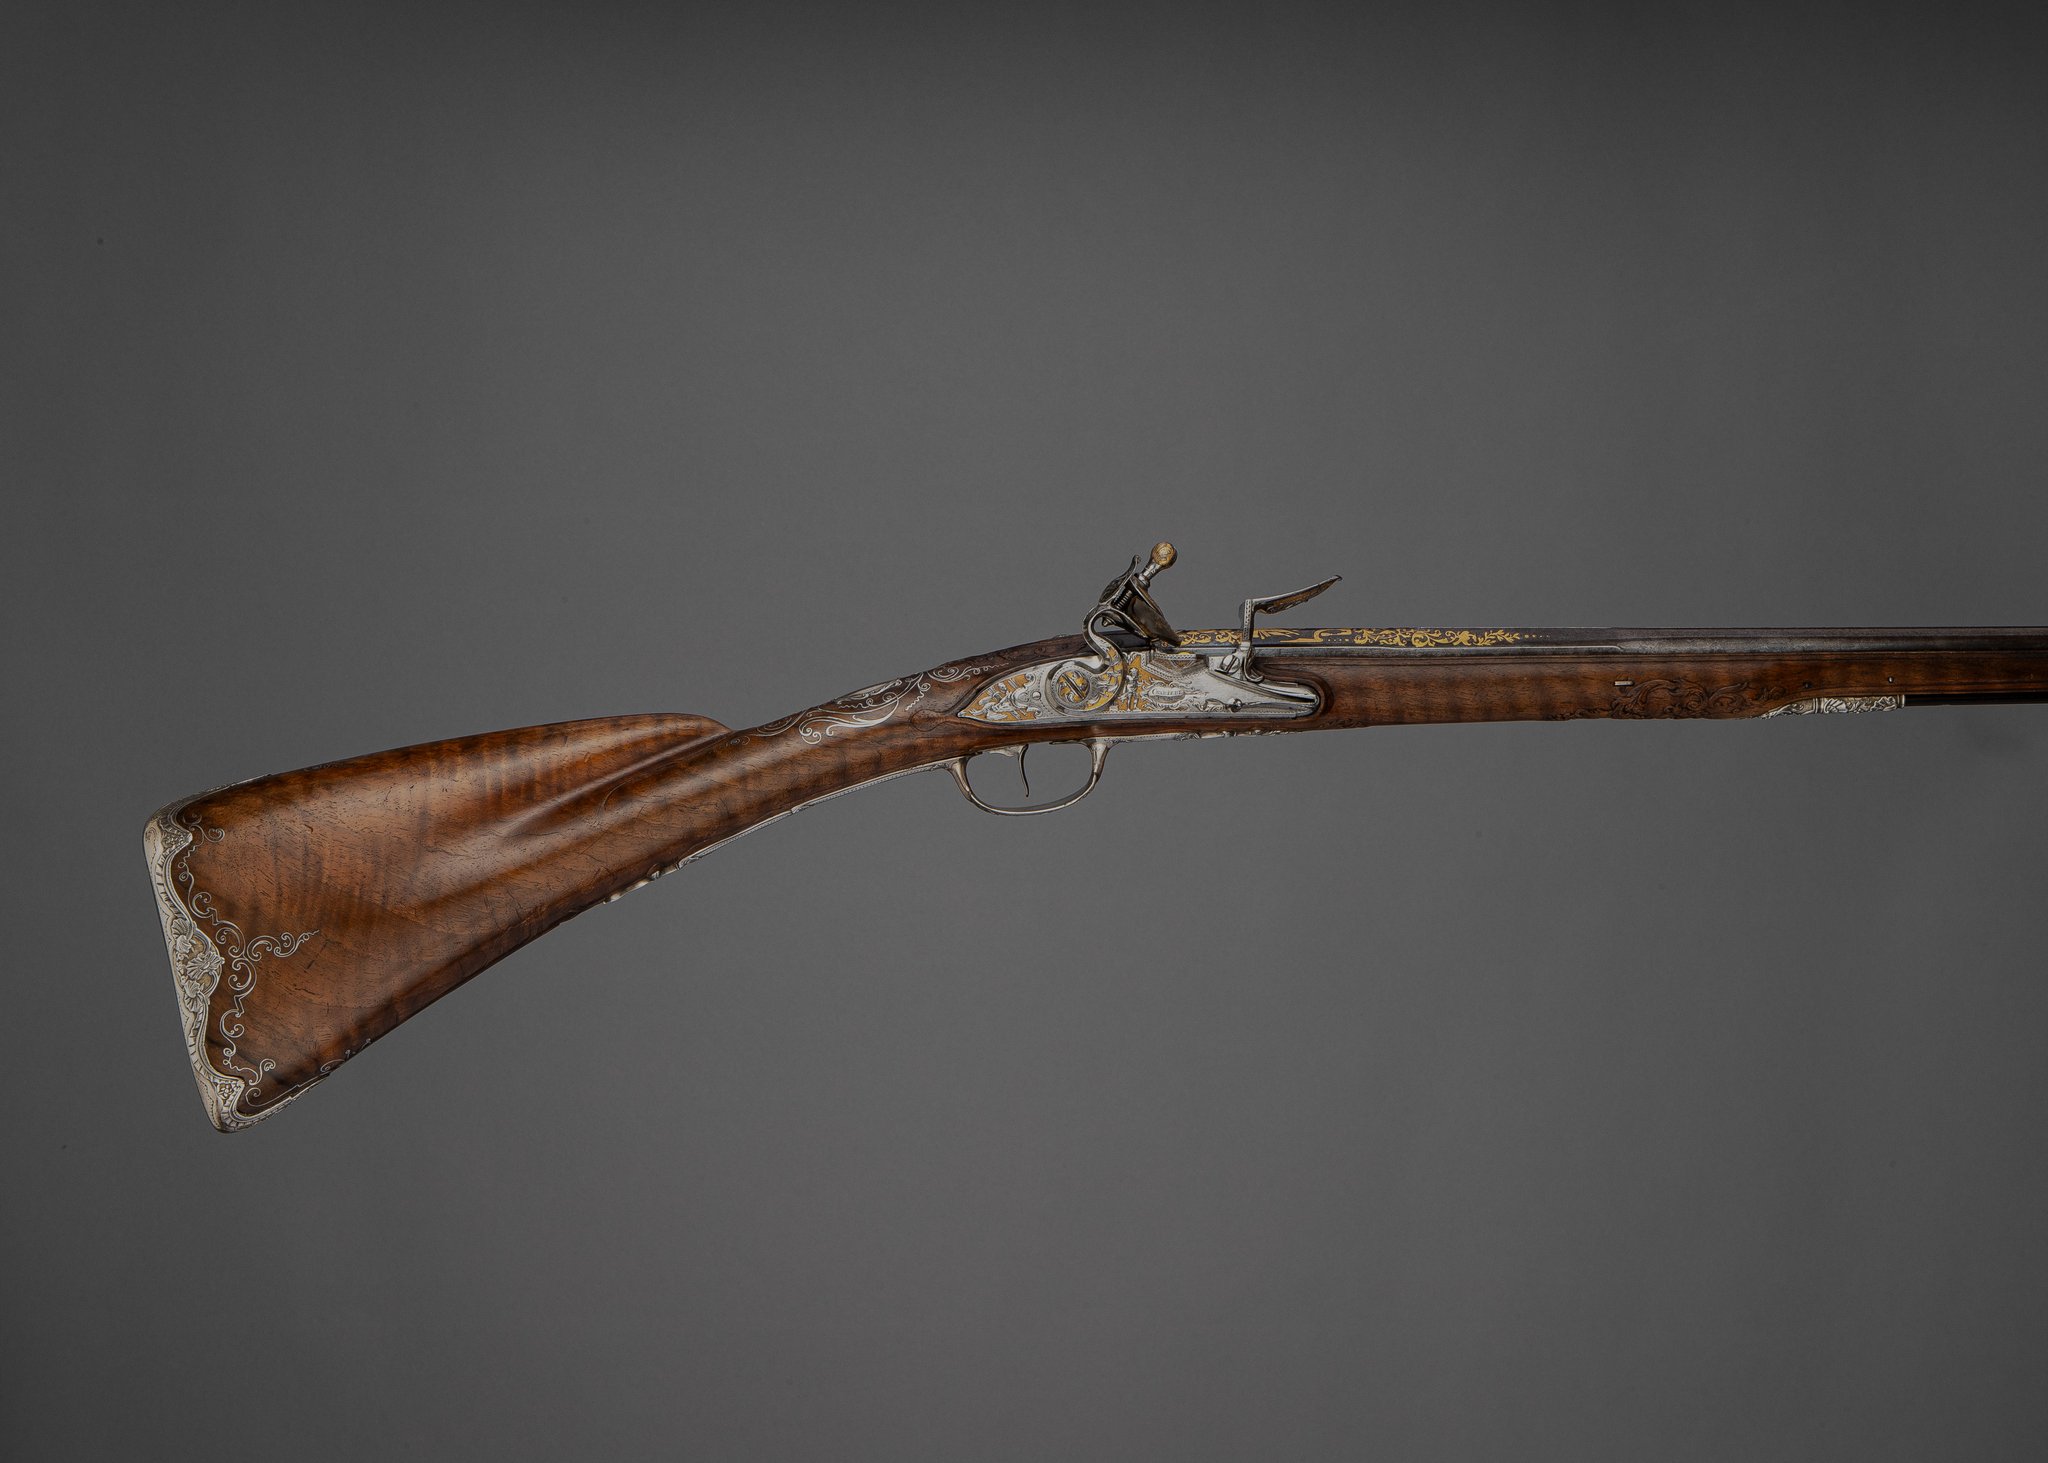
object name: flintlock pistol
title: Flintlock Gun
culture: french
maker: jean-joseph charrière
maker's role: gunsmith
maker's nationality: french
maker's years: 1744-1774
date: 1742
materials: gold, silver, steel, wood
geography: france